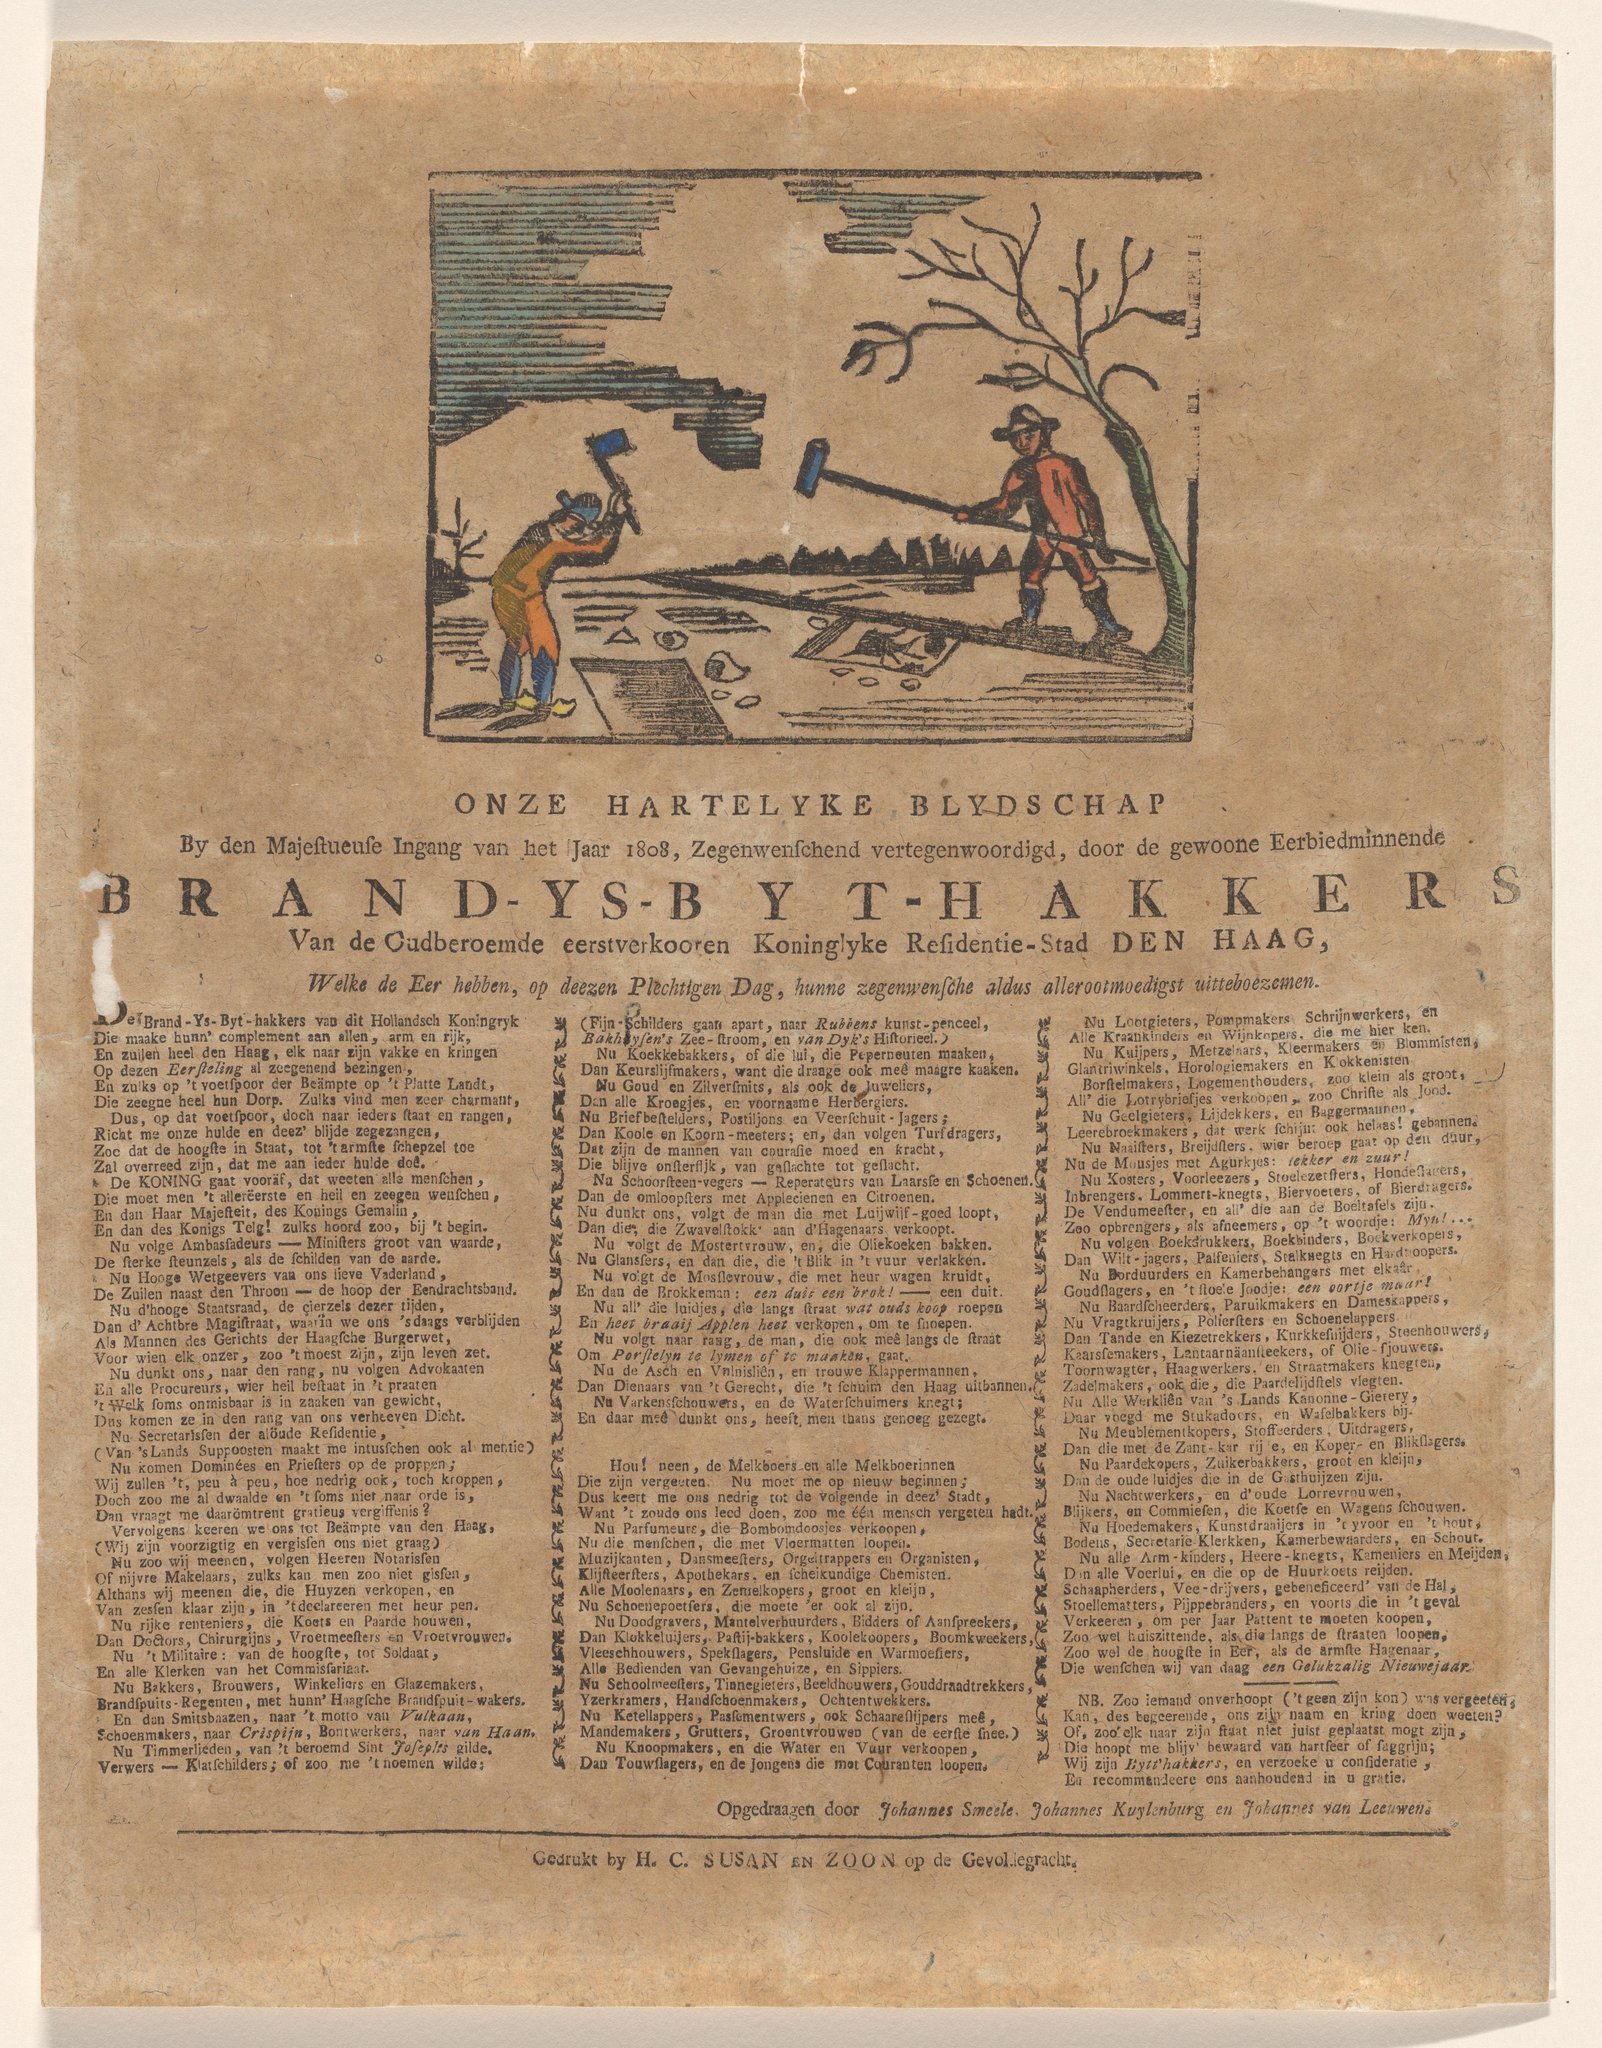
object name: print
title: Onze hartelyke blydschap by den majestueuse Ingang van het jaar 1808, zegenwenschend vertegenwoordigd, door de gewoone Eerbiedminnende Brand-Ys-Byt-hakkers van de oudberoemde eerstverkooren Koninglyke Residentie-Stad Den Haag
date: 1808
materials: ink, paper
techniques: hand coloring, letterpress printing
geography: the hague